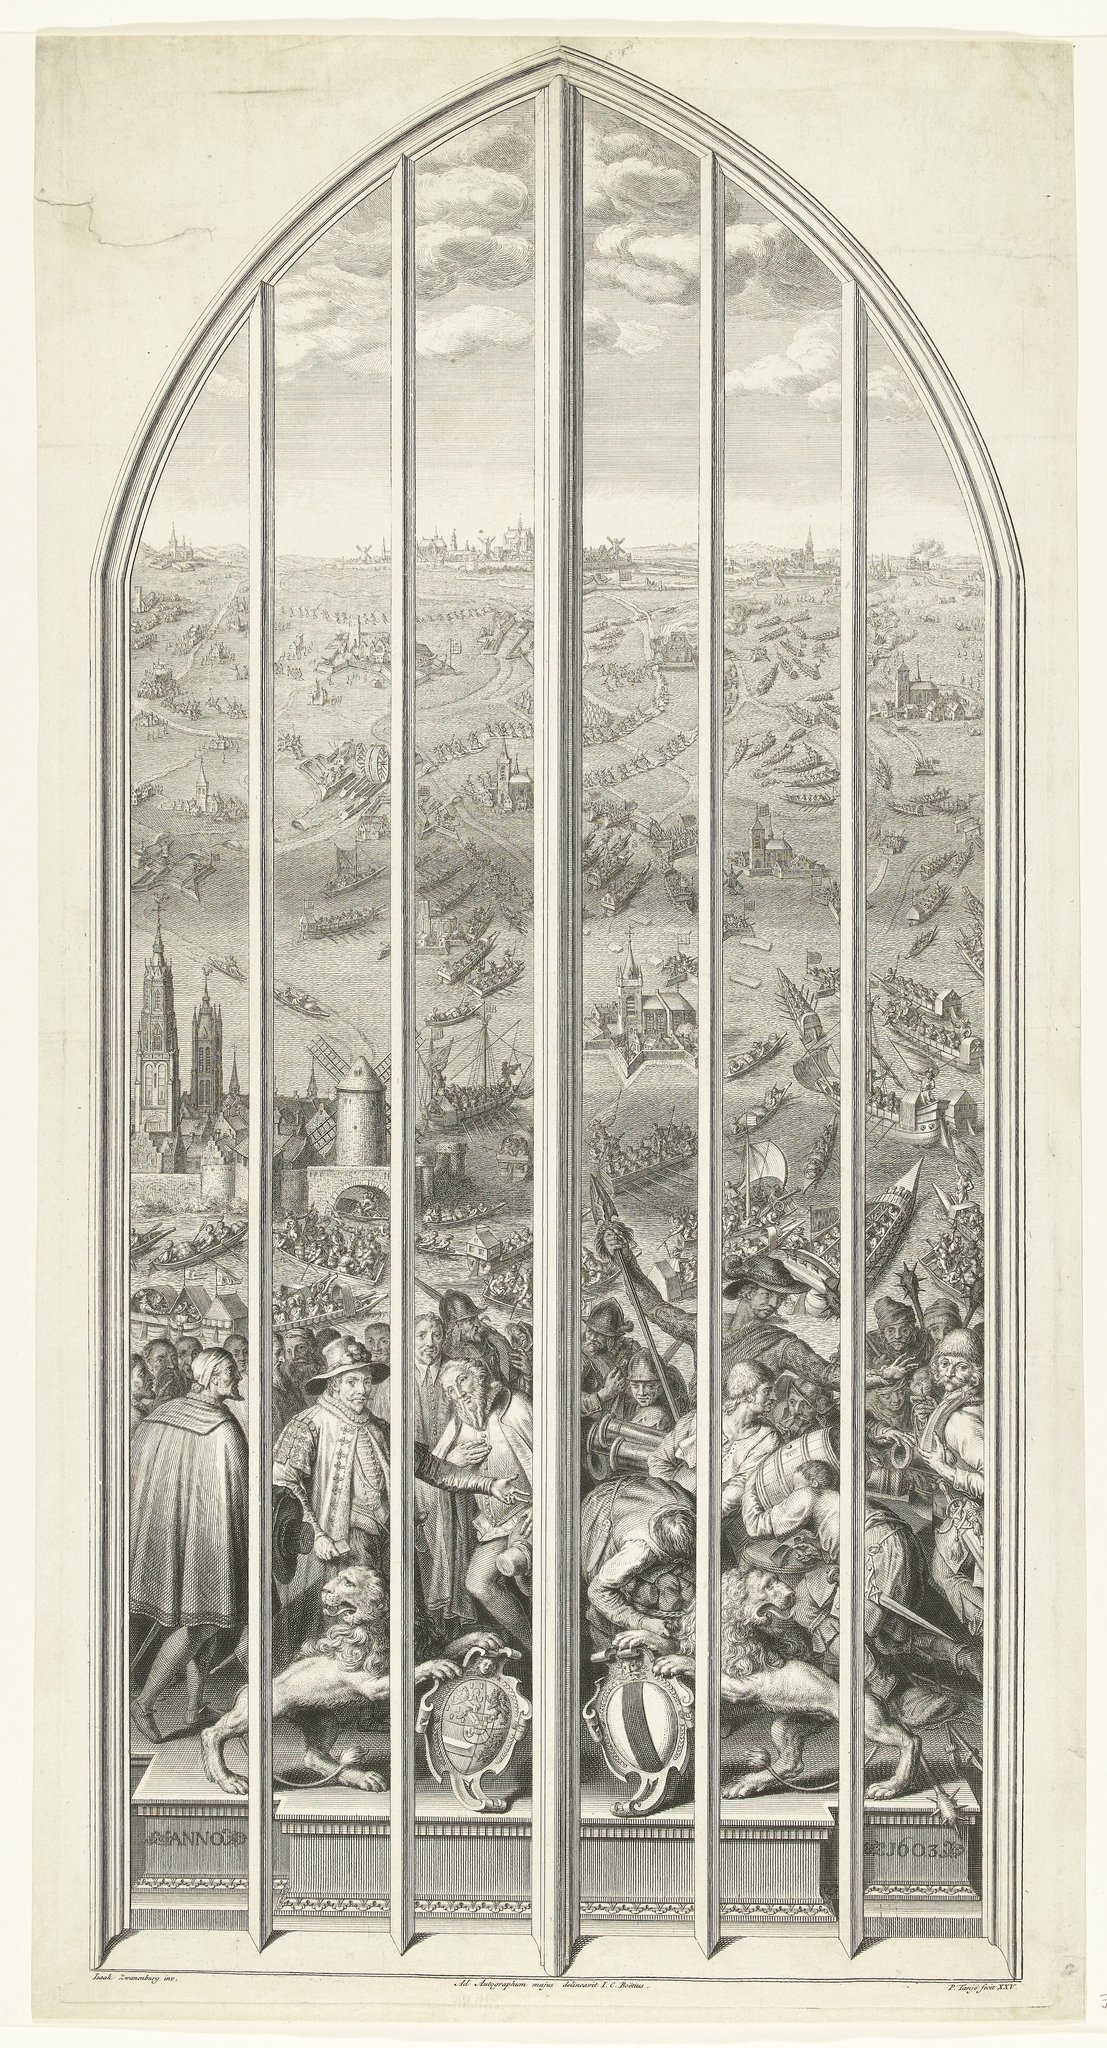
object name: print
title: Glasraam 25 in de Sint-Janskerk te Gouda: Het ontzet van Leiden, 1574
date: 1738-1754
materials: paper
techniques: etching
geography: amsterdam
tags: william i (prince of orange), raising the siege with outside assistance, relief, church-window, e.g. rose-window, leiden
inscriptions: collector's mark: ‘Archief’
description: Het vijfentwintigste glasraam in de Sint-Janskerk te Gouda met de voorstelling van het ontzet van Leiden op 3 oktober 1574. Op de voorgrond prins Willem I van Oranje staande tussen Leidenaren, soldaten en geuzen. Op de achtergrond vertrekken de boten van de geuzen richting Leiden. Onderaan: Anno 1603.